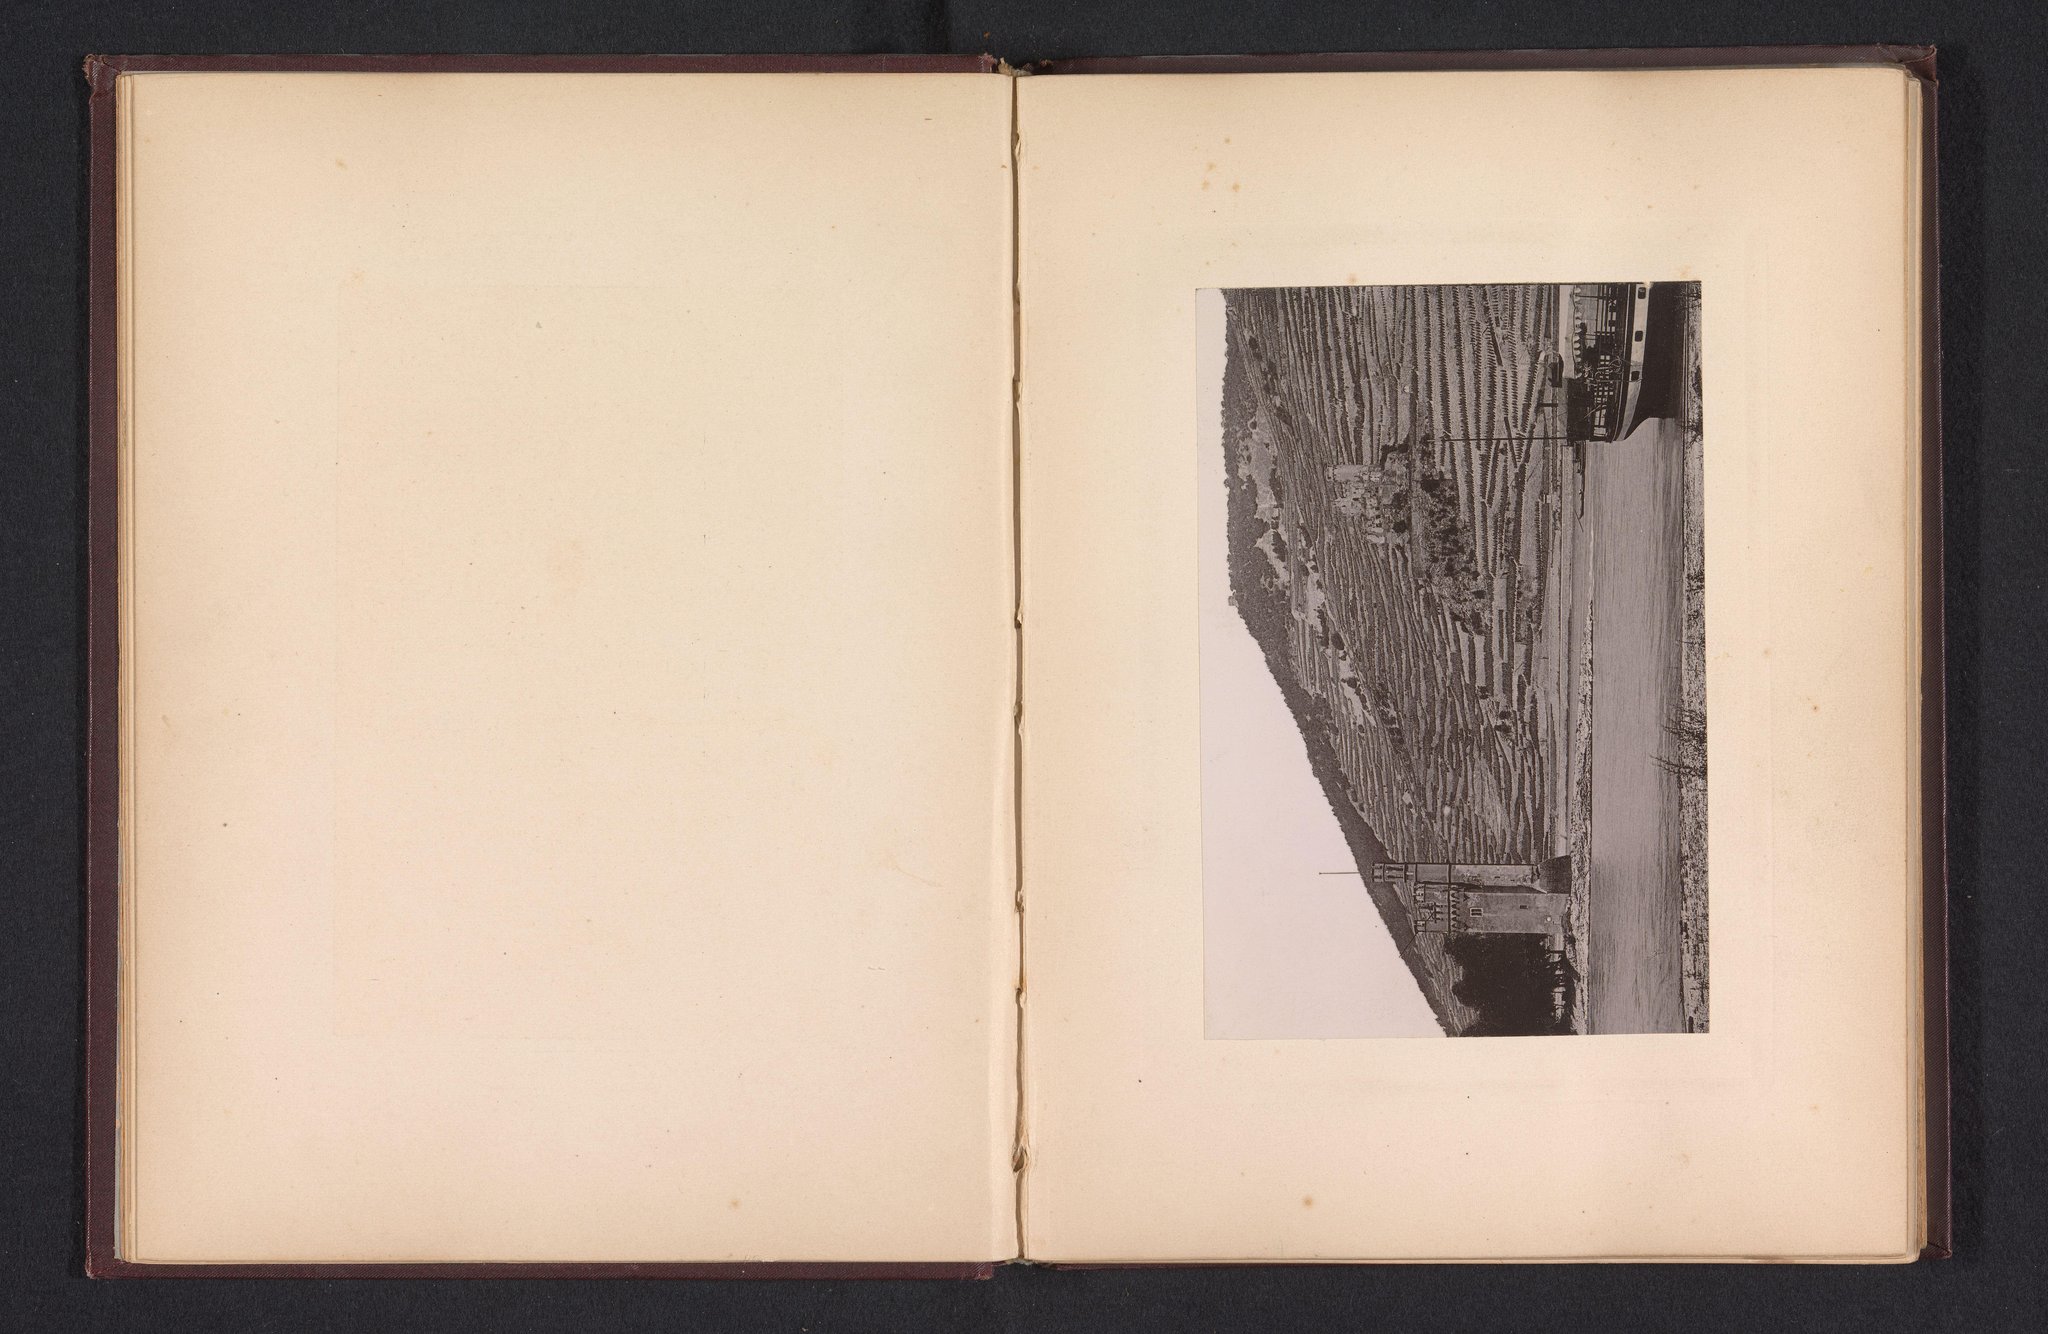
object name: photomechanical print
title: Gezicht op de Mäuseturm aan de Rijn bij Bingen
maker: Anonymous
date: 1881-1891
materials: paper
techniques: photograph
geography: bingen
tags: tower, clock tower ~ monumental adornment, river